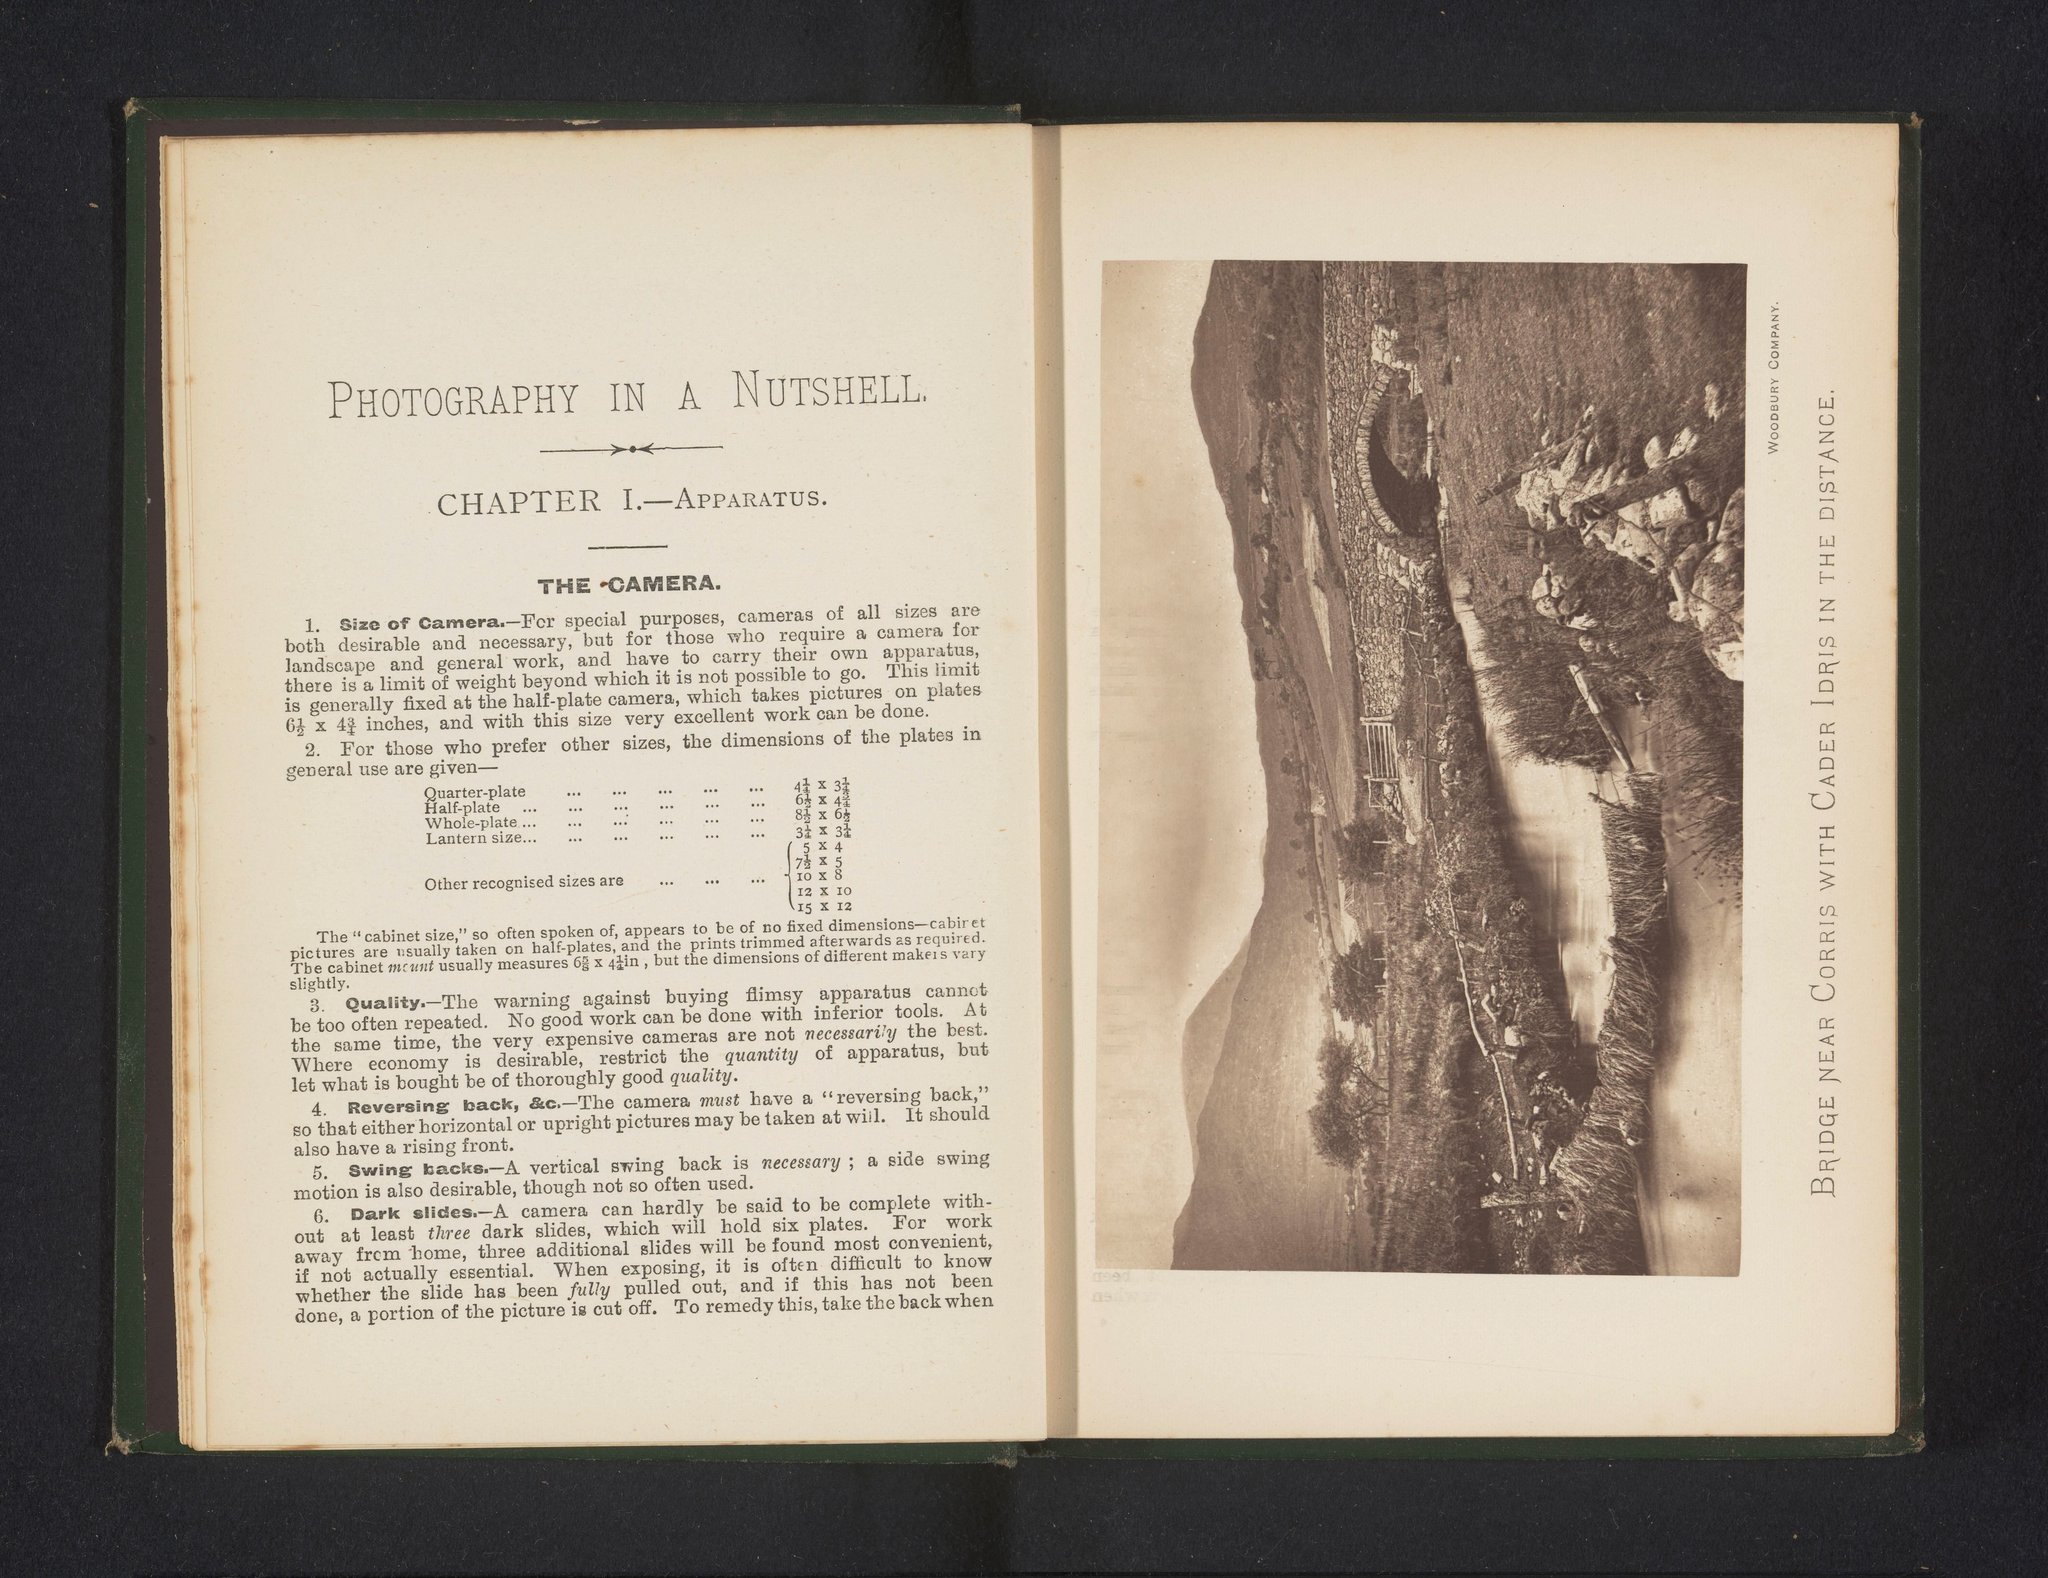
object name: page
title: Bridge near Corris with Cader Idris in the distance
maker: Anonymous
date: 1881-1891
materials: paper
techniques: woodburygravure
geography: wales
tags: bridge, mountains